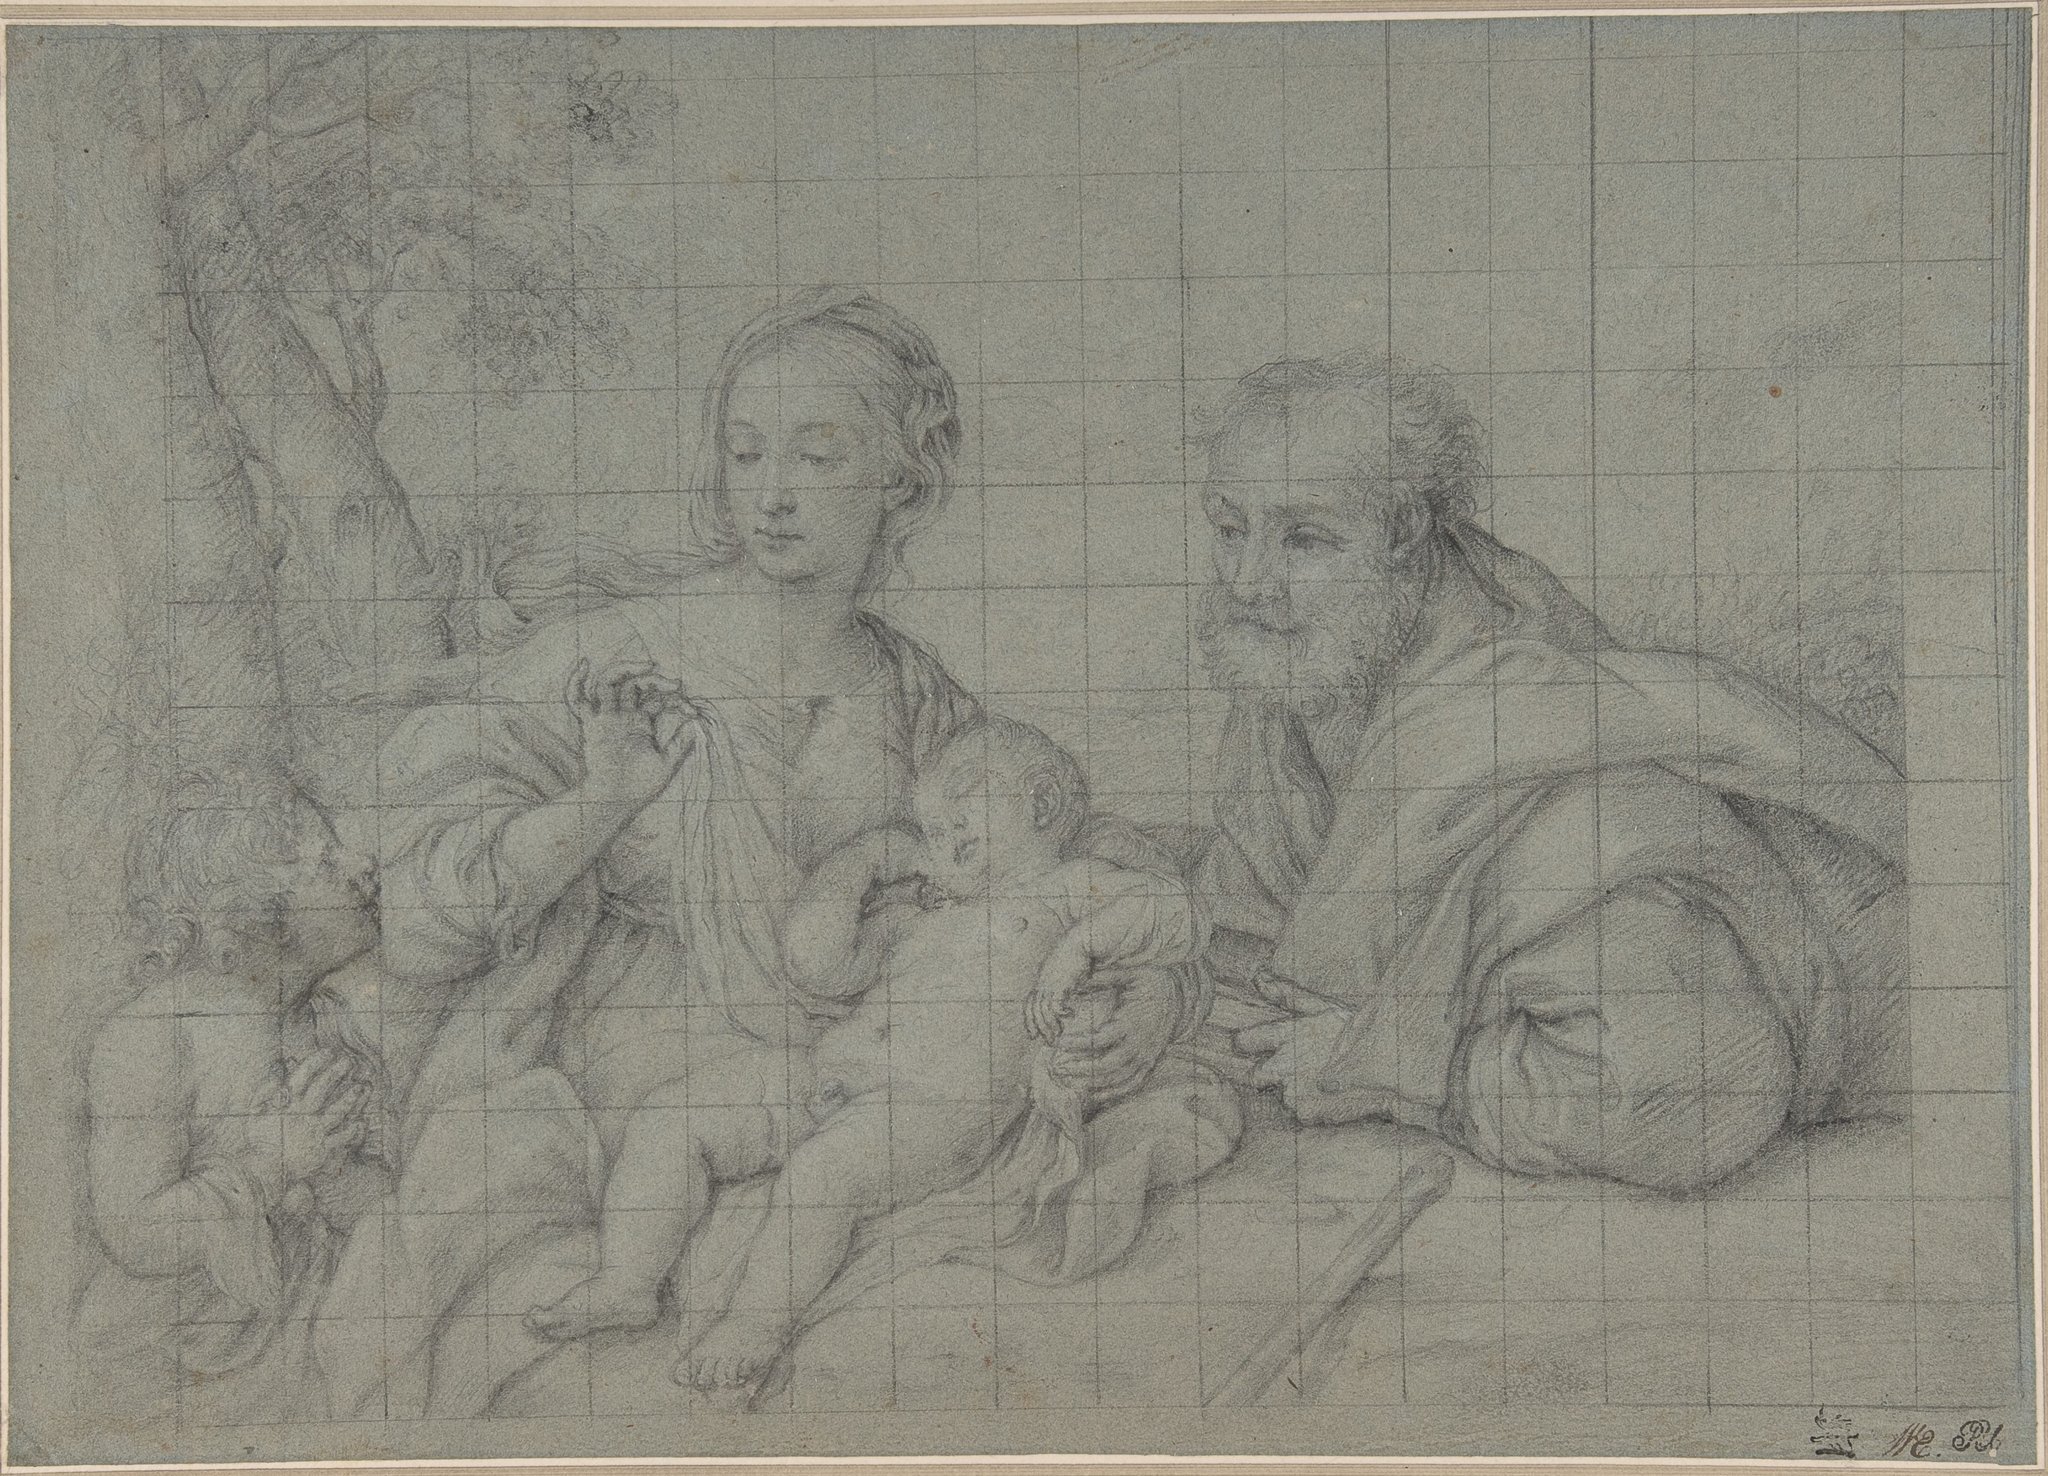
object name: drawing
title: The Holy Family with the Infant Saint John the Baptist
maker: sassoferrato (giovanni battista salvi)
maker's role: artist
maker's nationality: italian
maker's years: 1609-1685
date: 1609-1685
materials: chalk, paper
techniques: drawing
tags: infants,trees,holy family,saint john the baptist